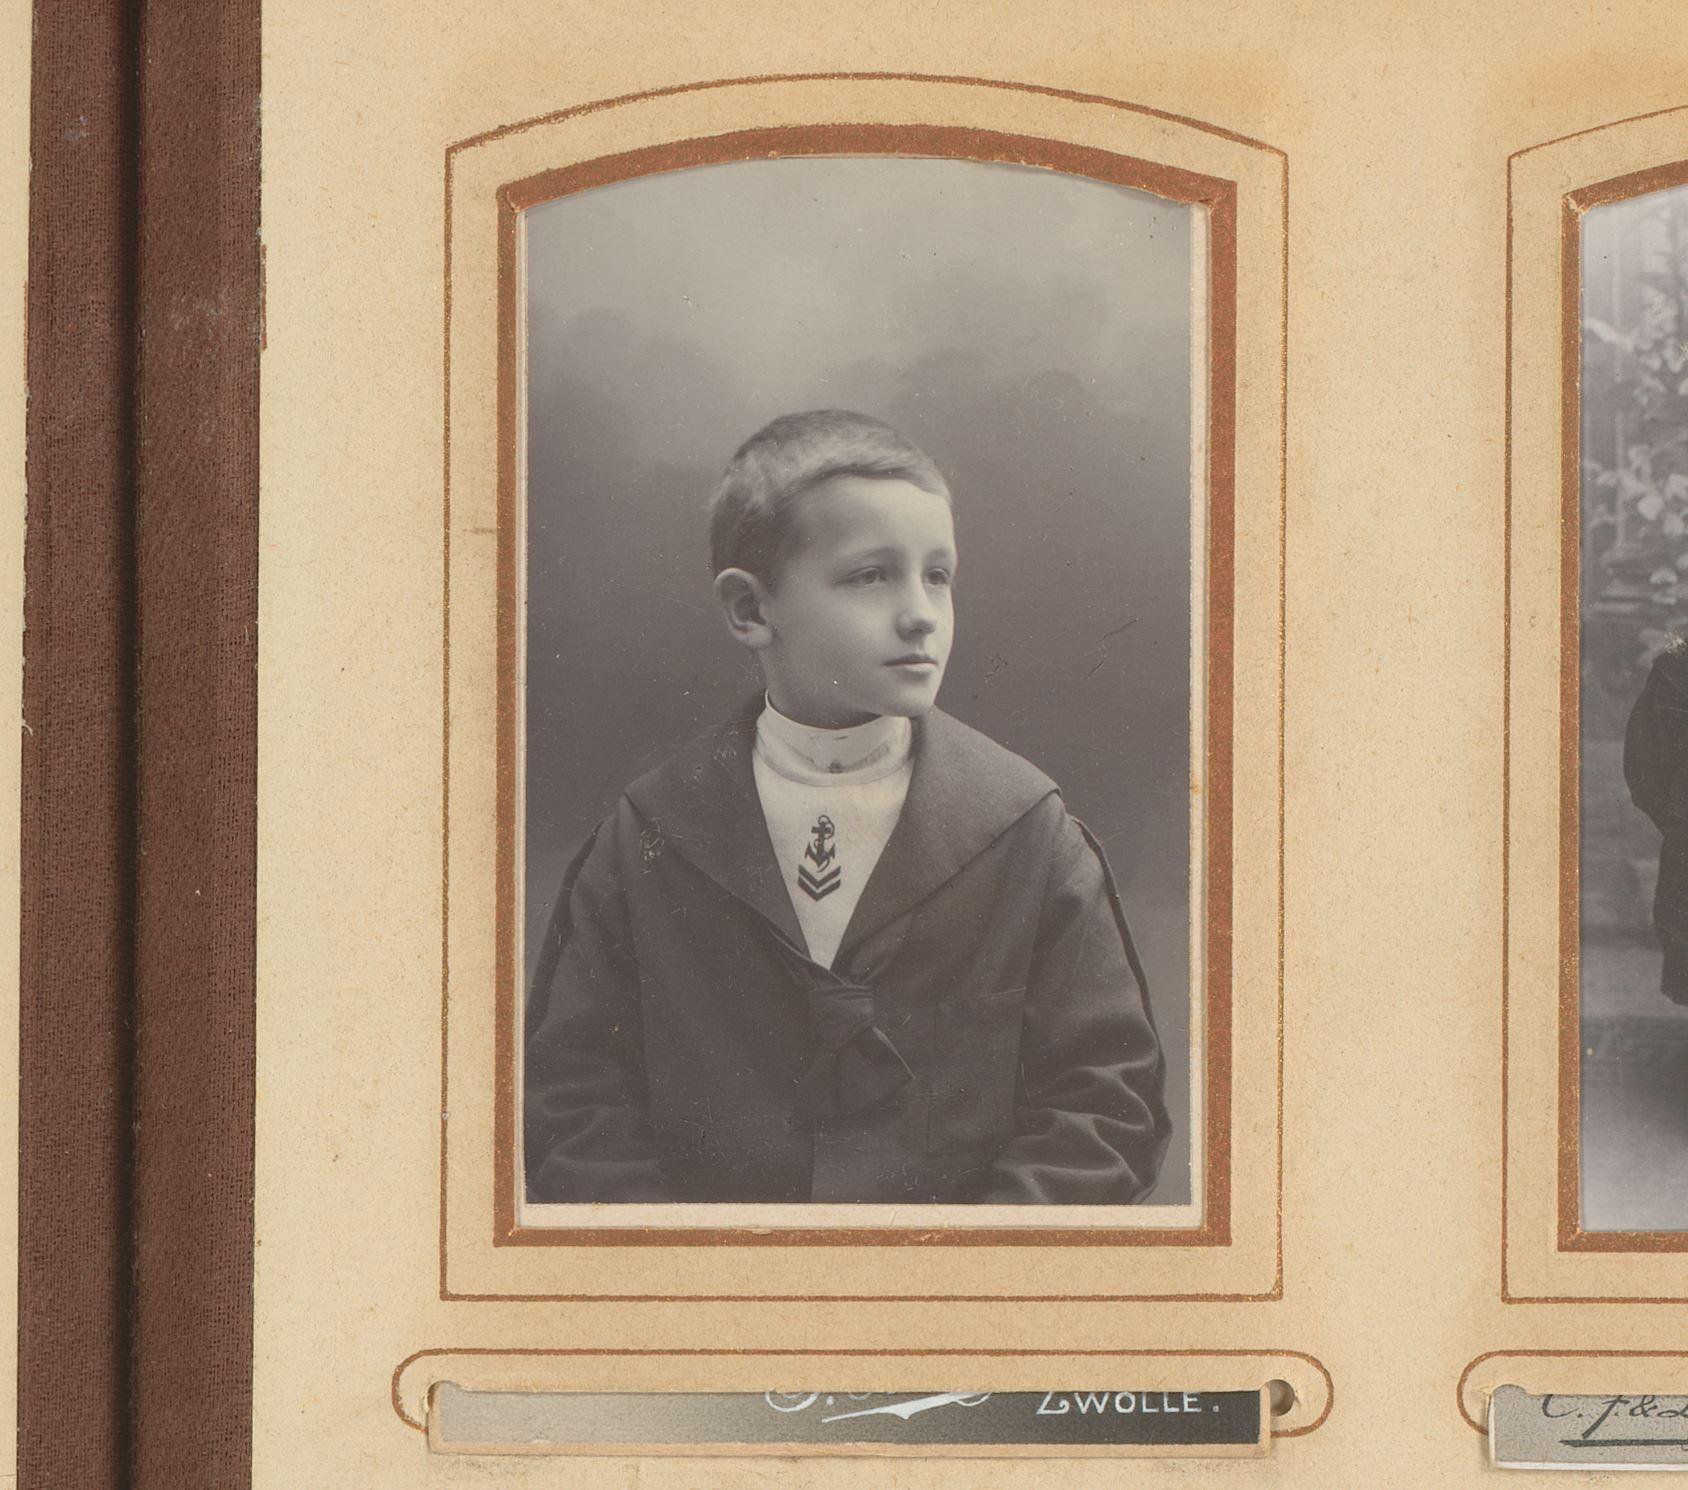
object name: carte de visite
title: Portret van een jongen in matrozenpak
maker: jan anthonie eelsingh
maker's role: fotograaf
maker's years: 1866-1949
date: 1892-1912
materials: cardboard, photographic support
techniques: collodion silver print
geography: zwolle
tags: ensemble of pieces of clothing: sailor suit, boy (child between toddler and youth)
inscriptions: inscription: ‘J.A. Eelsingh/ Zwolle’